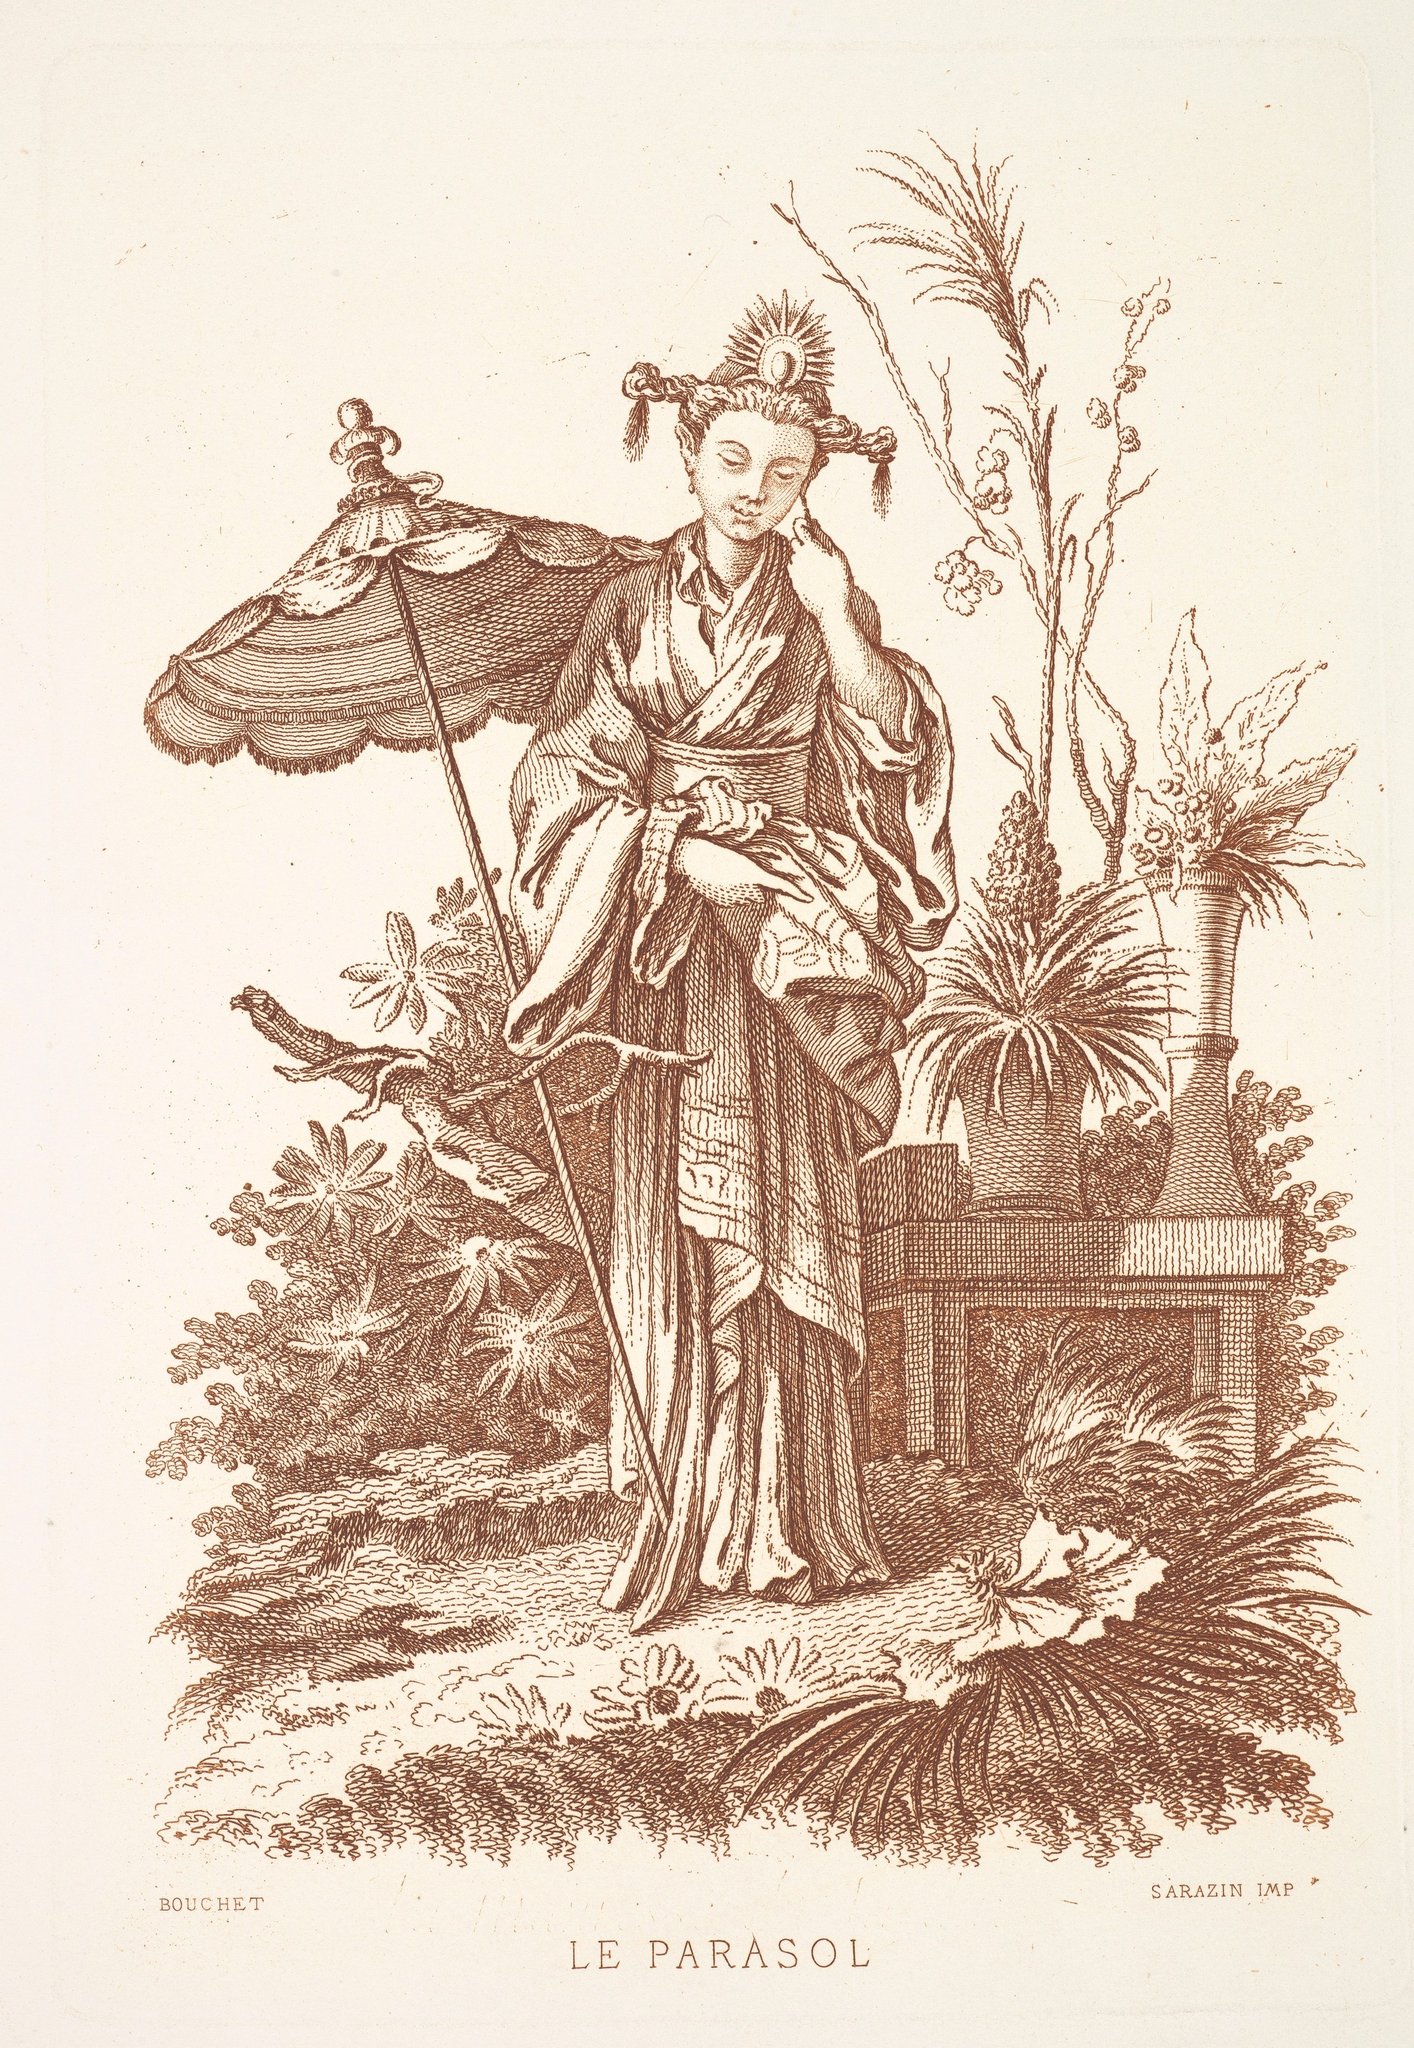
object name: print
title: The Parasol, from "L'Artiste"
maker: françois boucher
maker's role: artist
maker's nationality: french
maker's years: 1703-1770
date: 1801-1900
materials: ink, paper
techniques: etching, printing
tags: women